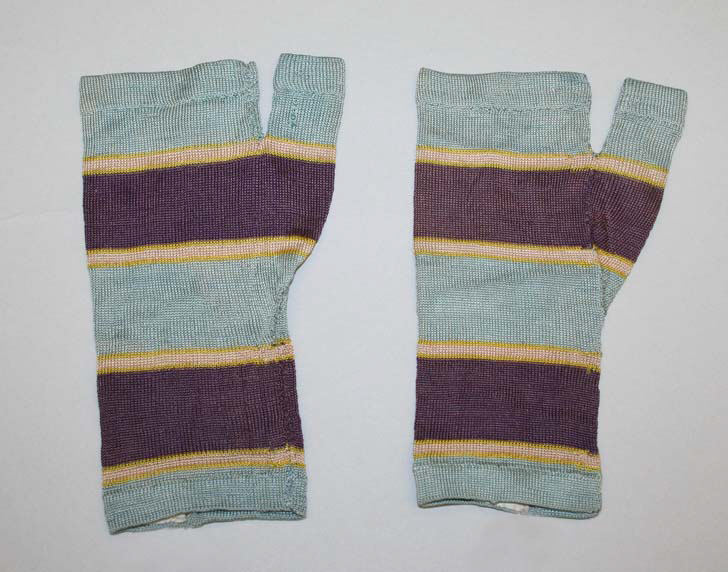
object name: mitt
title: Mitts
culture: italian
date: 1850-1860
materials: silk